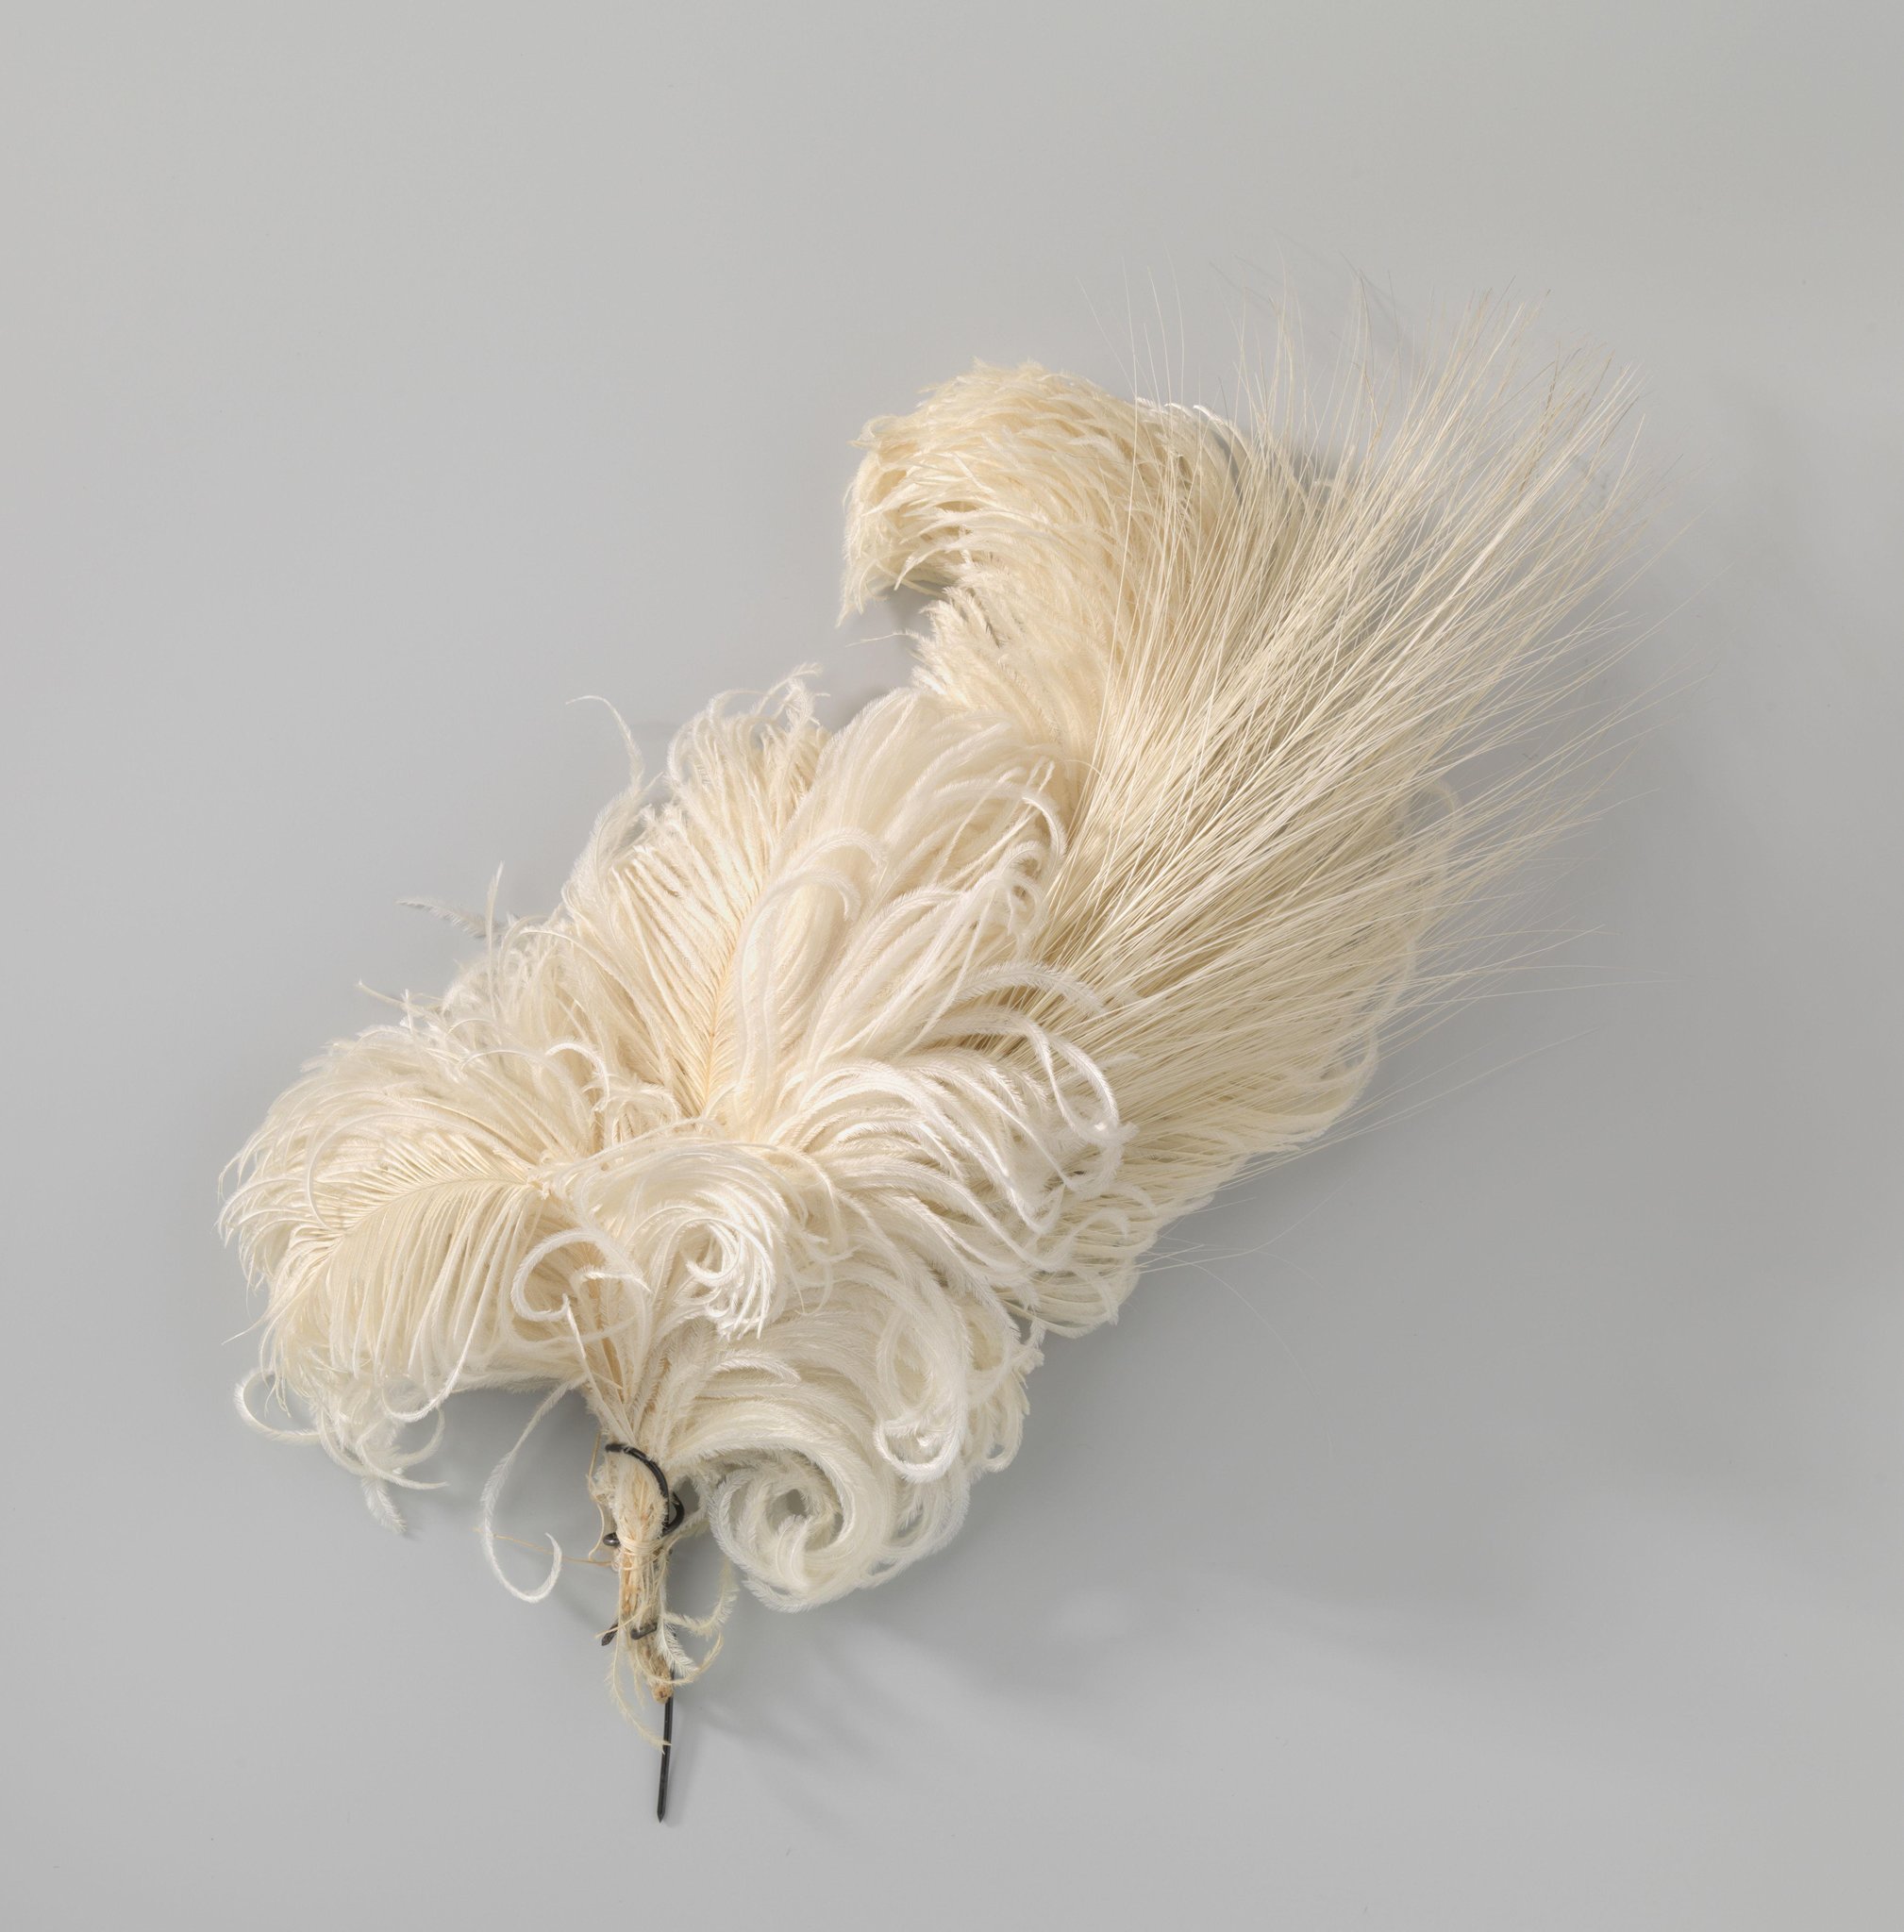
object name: hoedengarneersel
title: Toef van verschillende witte veren, waaronder struisveren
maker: Anonymous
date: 1880-1940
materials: feather, metal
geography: western europe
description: Toef van verschillende witte veren, waaronder struisveren.